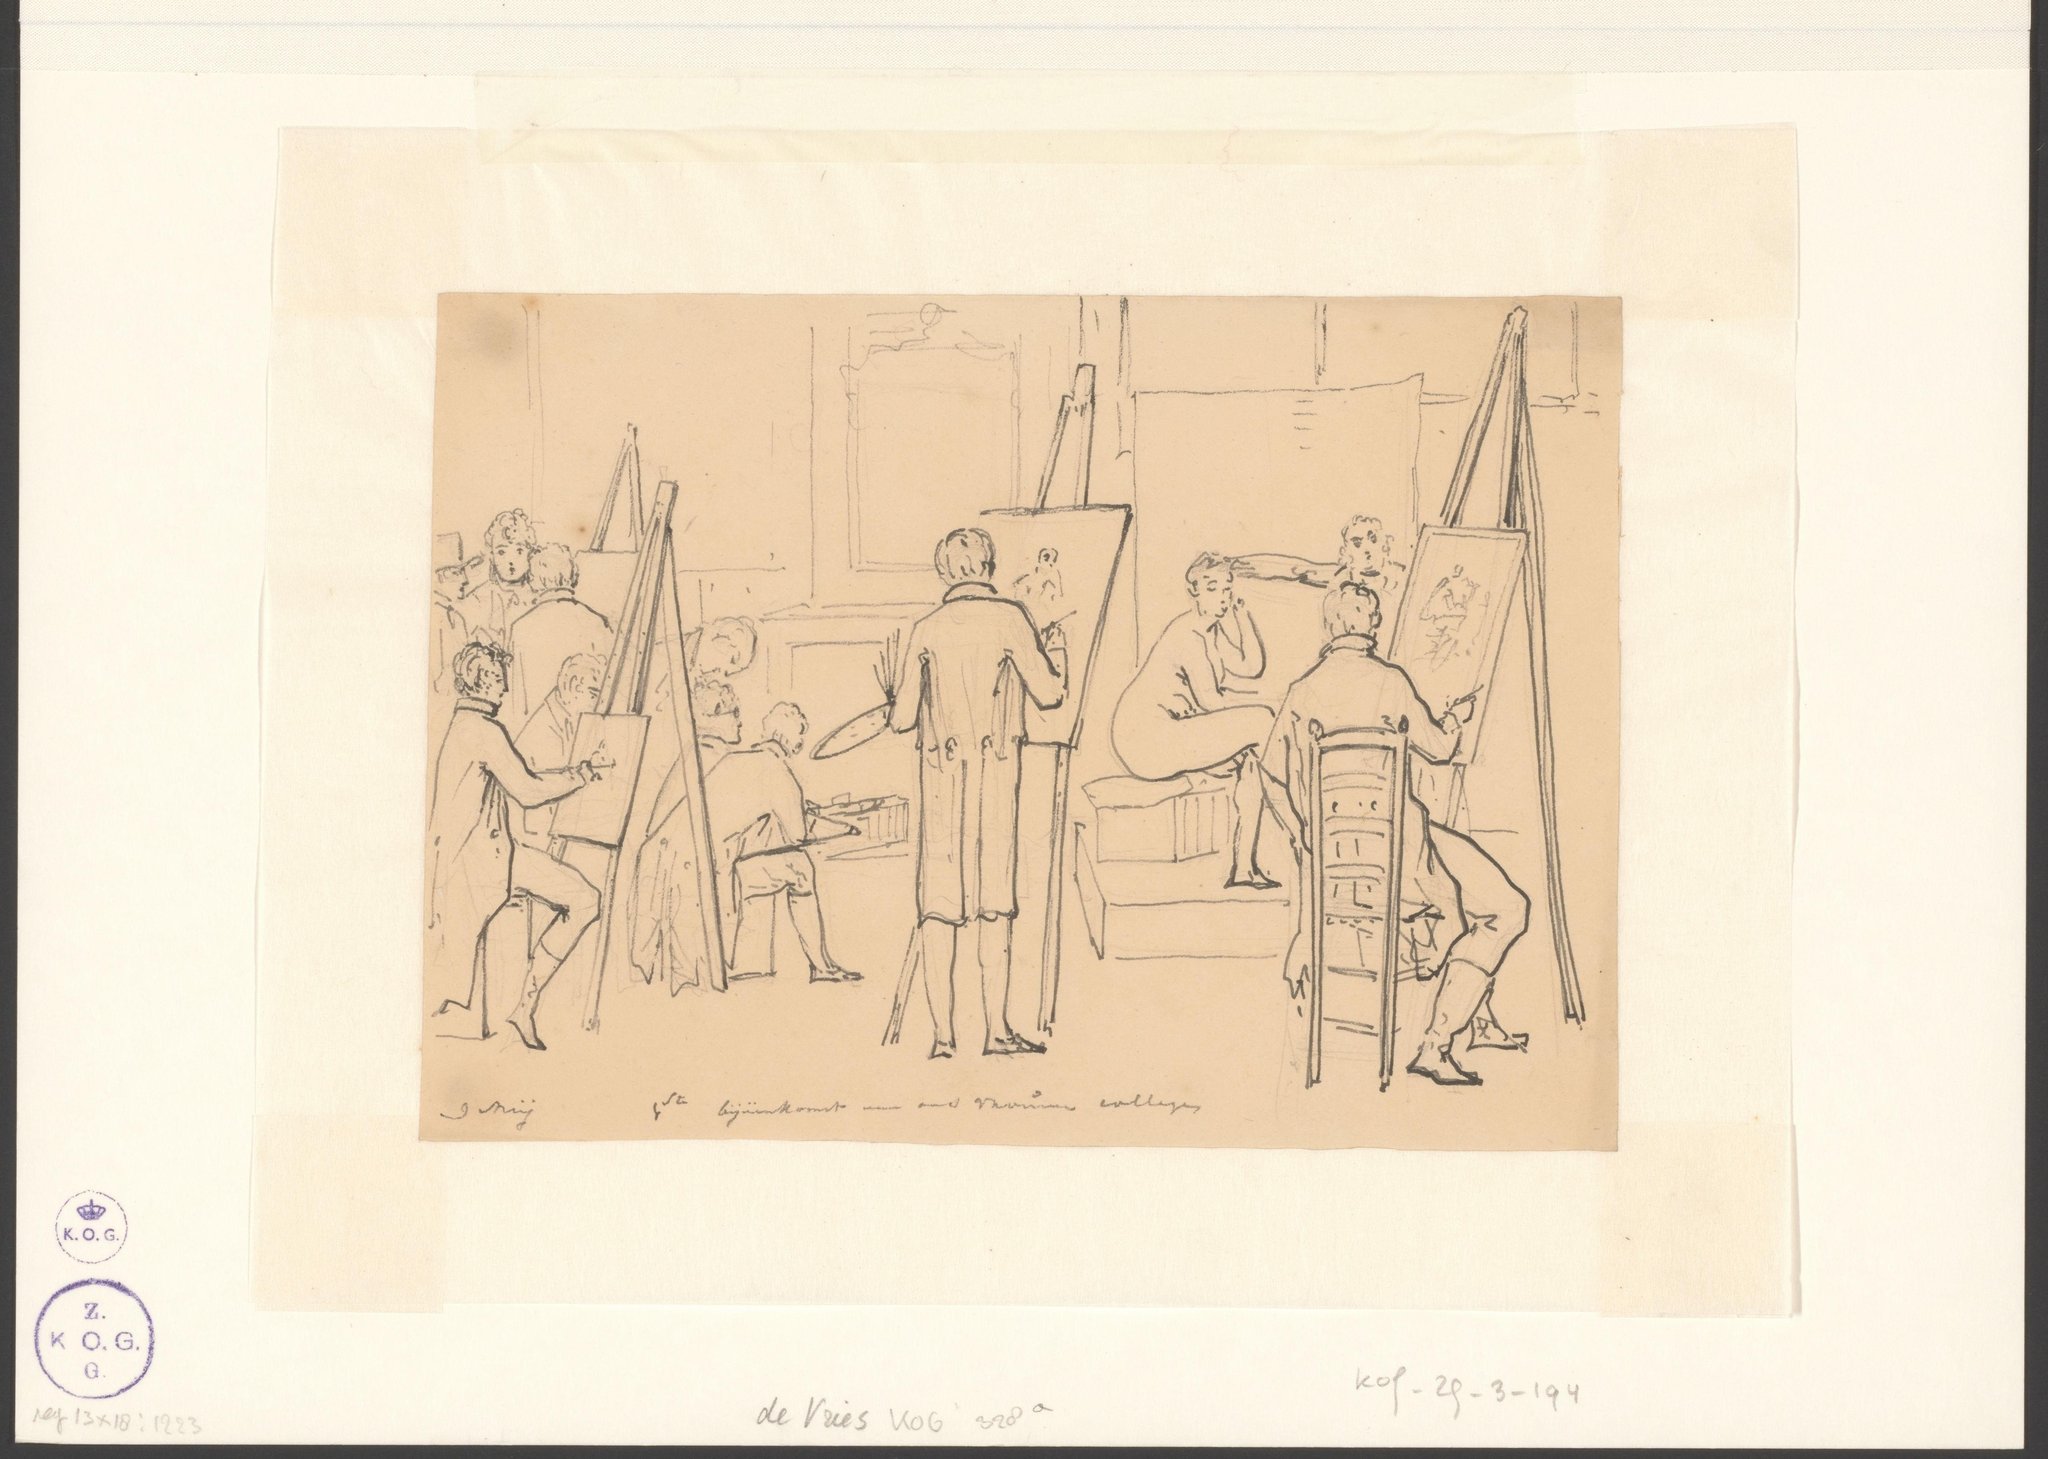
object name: drawing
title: Eerste bijeenkomst van het vrouwencollege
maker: christiaan andriessen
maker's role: draughtsman, print maker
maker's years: 1775-1846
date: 1805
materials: ink, paper, pencil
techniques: pen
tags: amsterdam, draughtsman, christiaan andriessen, painter working from live model, working situations ~ painter, painter working from nude model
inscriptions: inscription: ‘9 meij 1ste bijeenkomst van ons Vrouwen college’, collector's mark: Lugt 1641a, collector's mark: Lugt 1641, signature: ‘J Andriessen’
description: Aangezien er op de Stadstekenacademie alleen naar mannelijke naaktmodellen werd getekend, organiseert Christiaan Andriessen samen met zijn vader tekenlessen met een vrouwelijk naaktmodel bij hen thuis. Alle afgebeelde aanwezige kunstenaars zijn man.